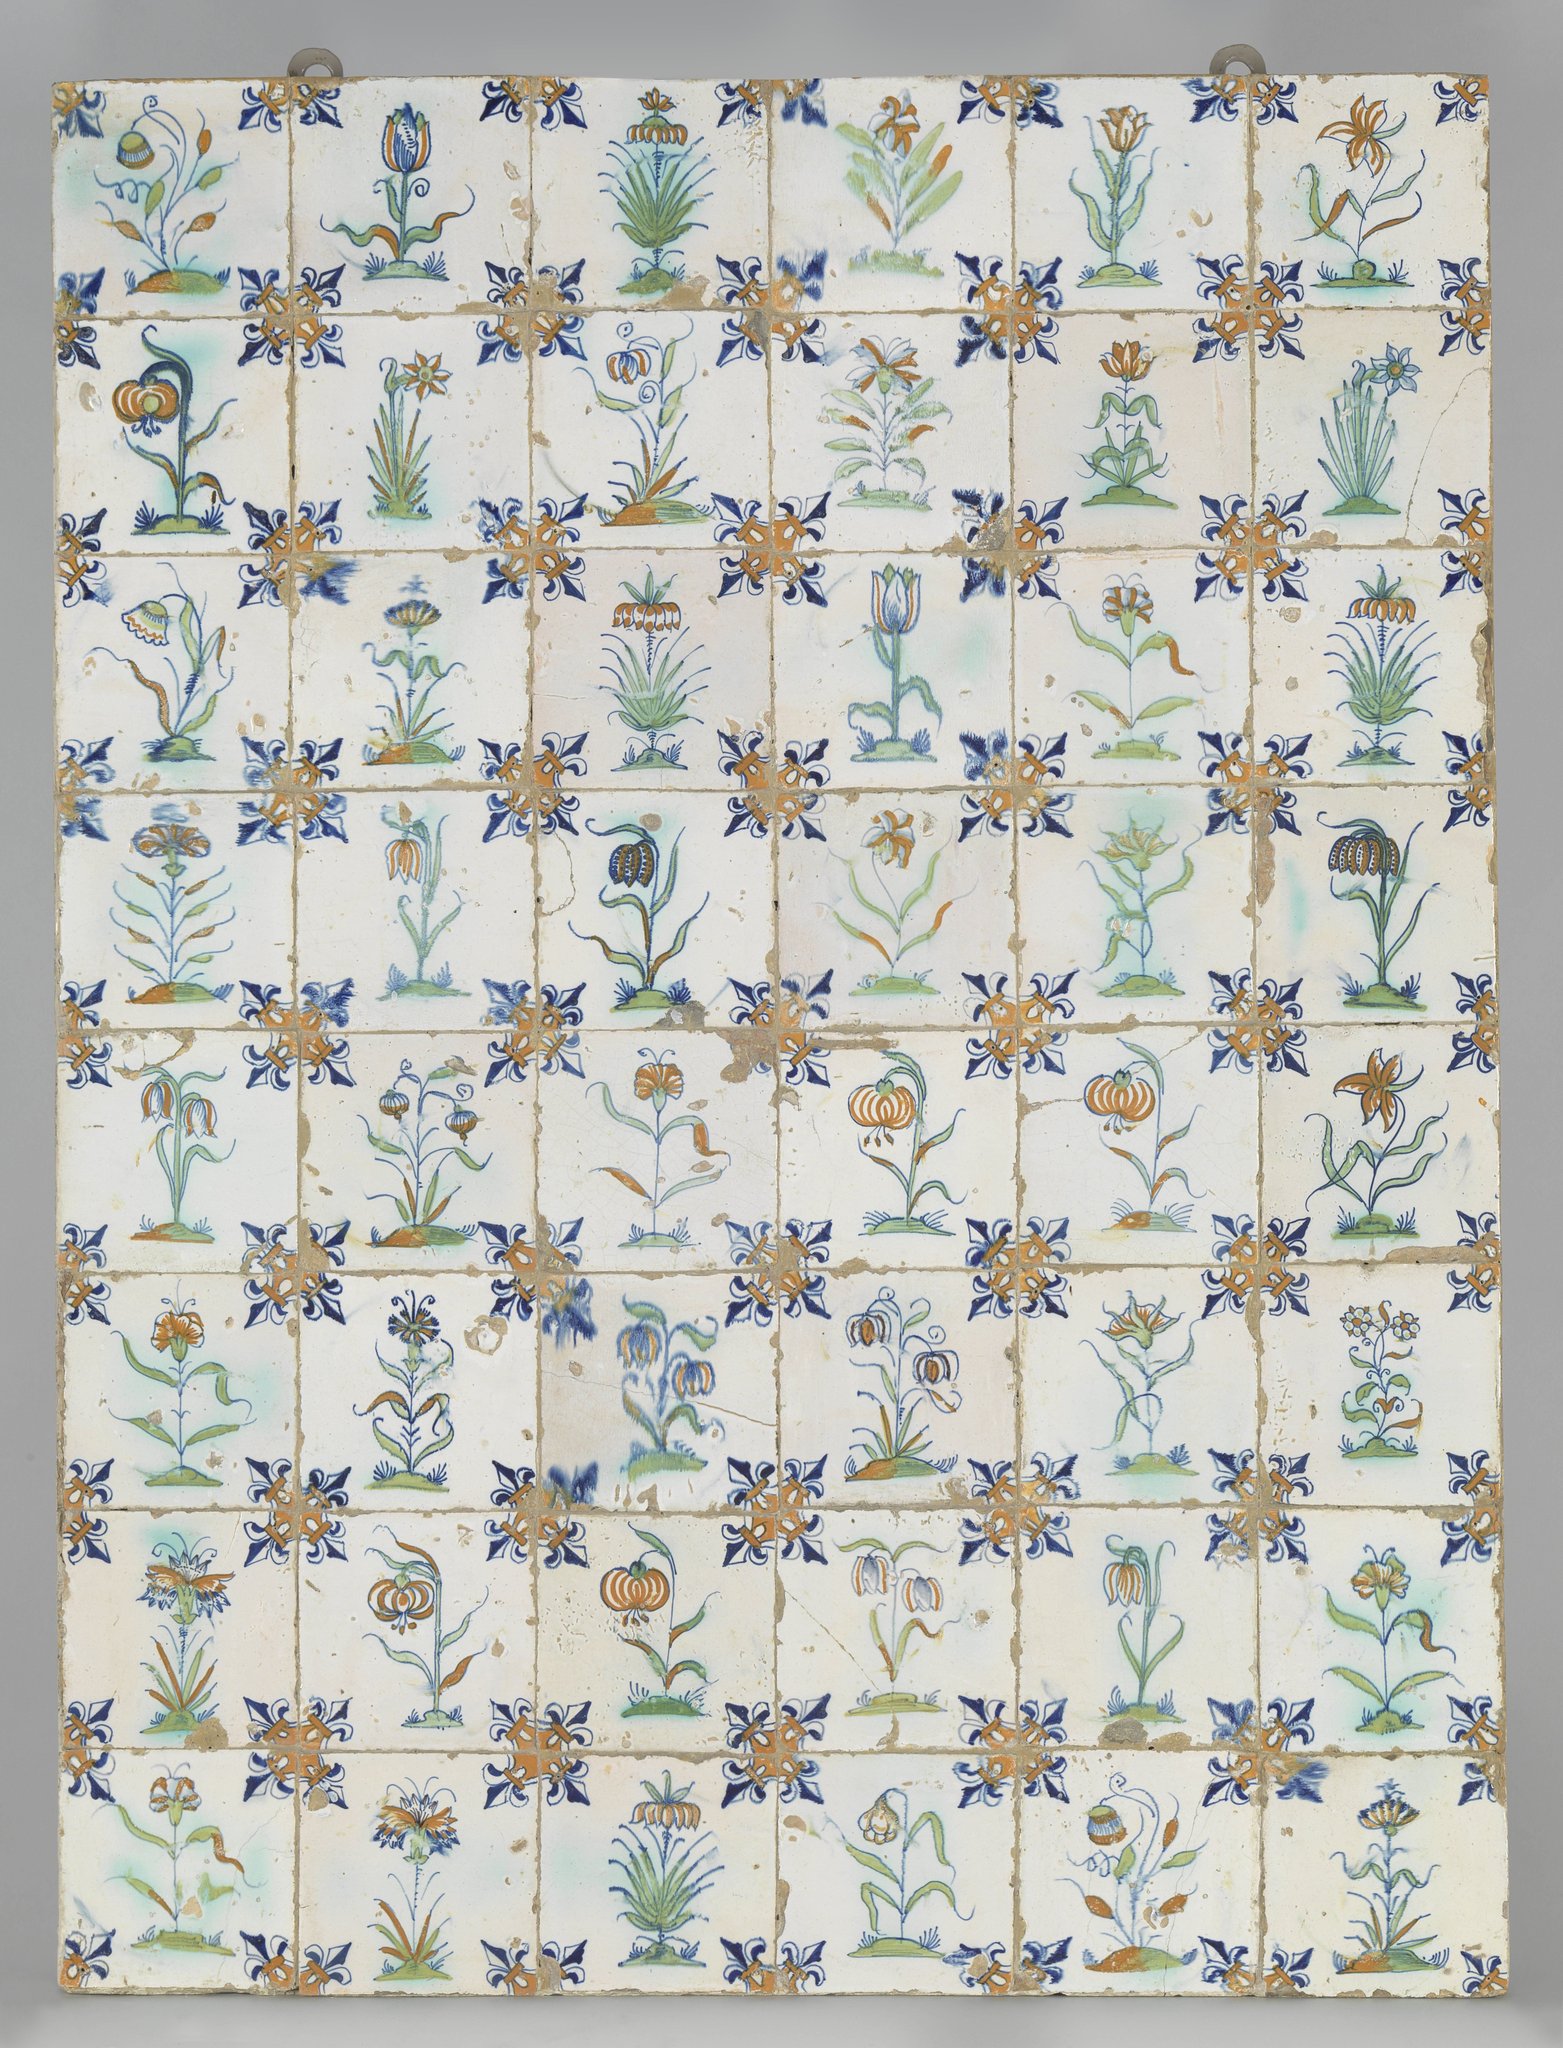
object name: tegelveld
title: Veld van achtenveertig tegels met bloemen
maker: Anonymous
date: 1640-1660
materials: earthenware, glaze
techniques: maiolica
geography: netherlands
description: Veld van achtenveertig tegels (8 x 6) elk met een veelkleurige (blauw, groen en oranje) bloem op een grond. In de hoeken, een lelie.